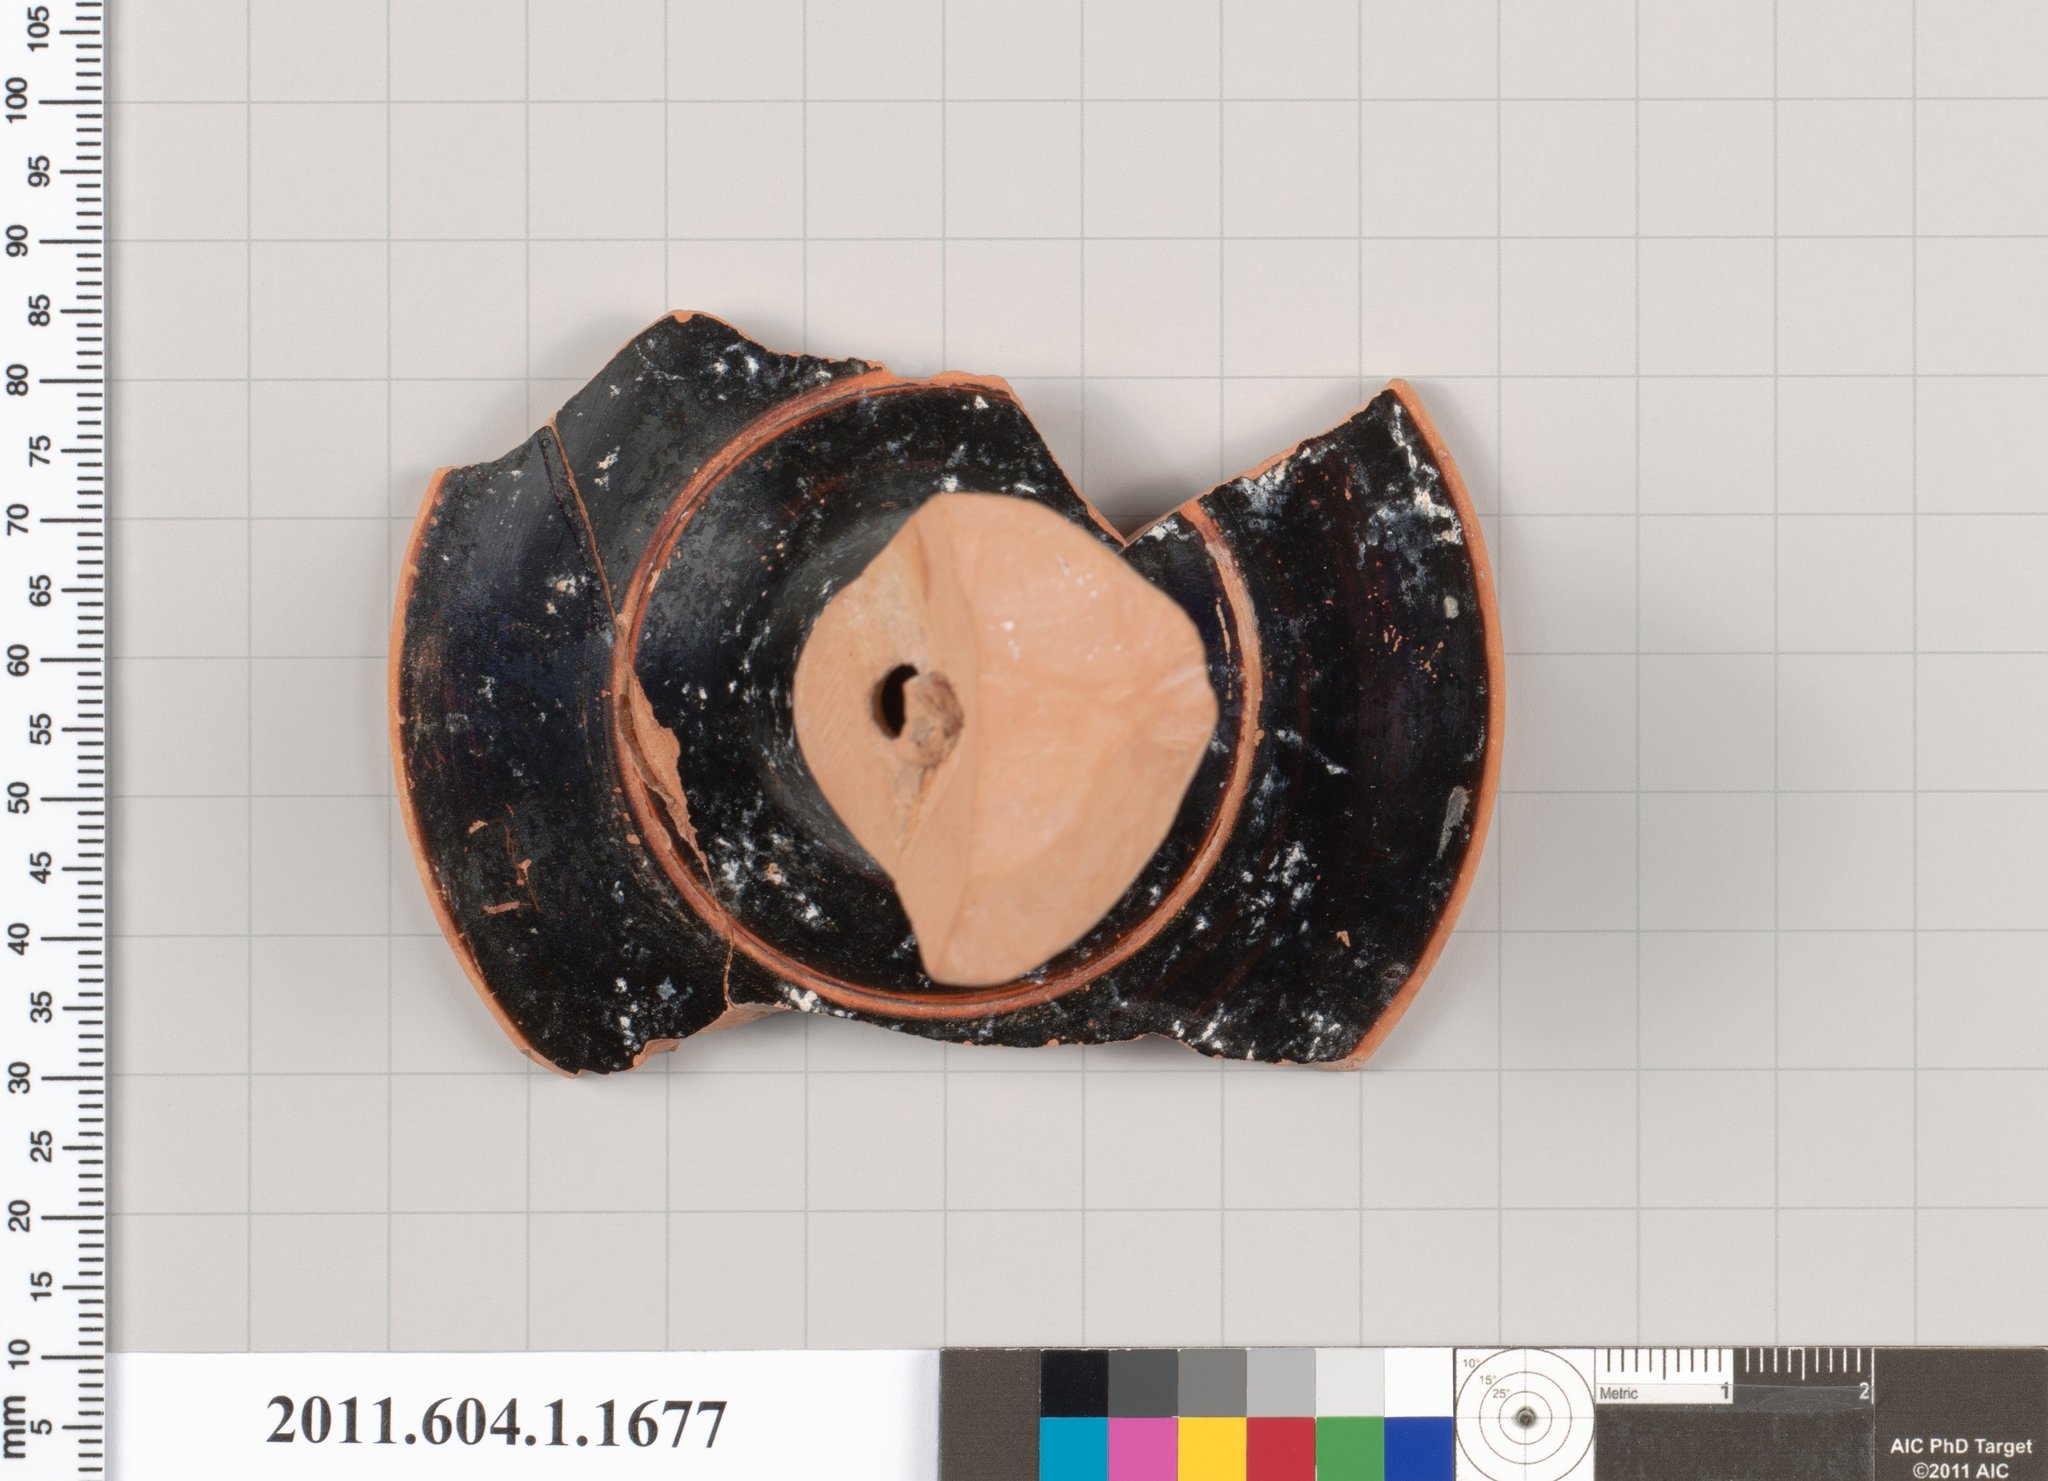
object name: kylix fragment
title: Terracotta fragment of a kylix (drinking cup)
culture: greek, attic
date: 500-401 BCE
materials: terracotta